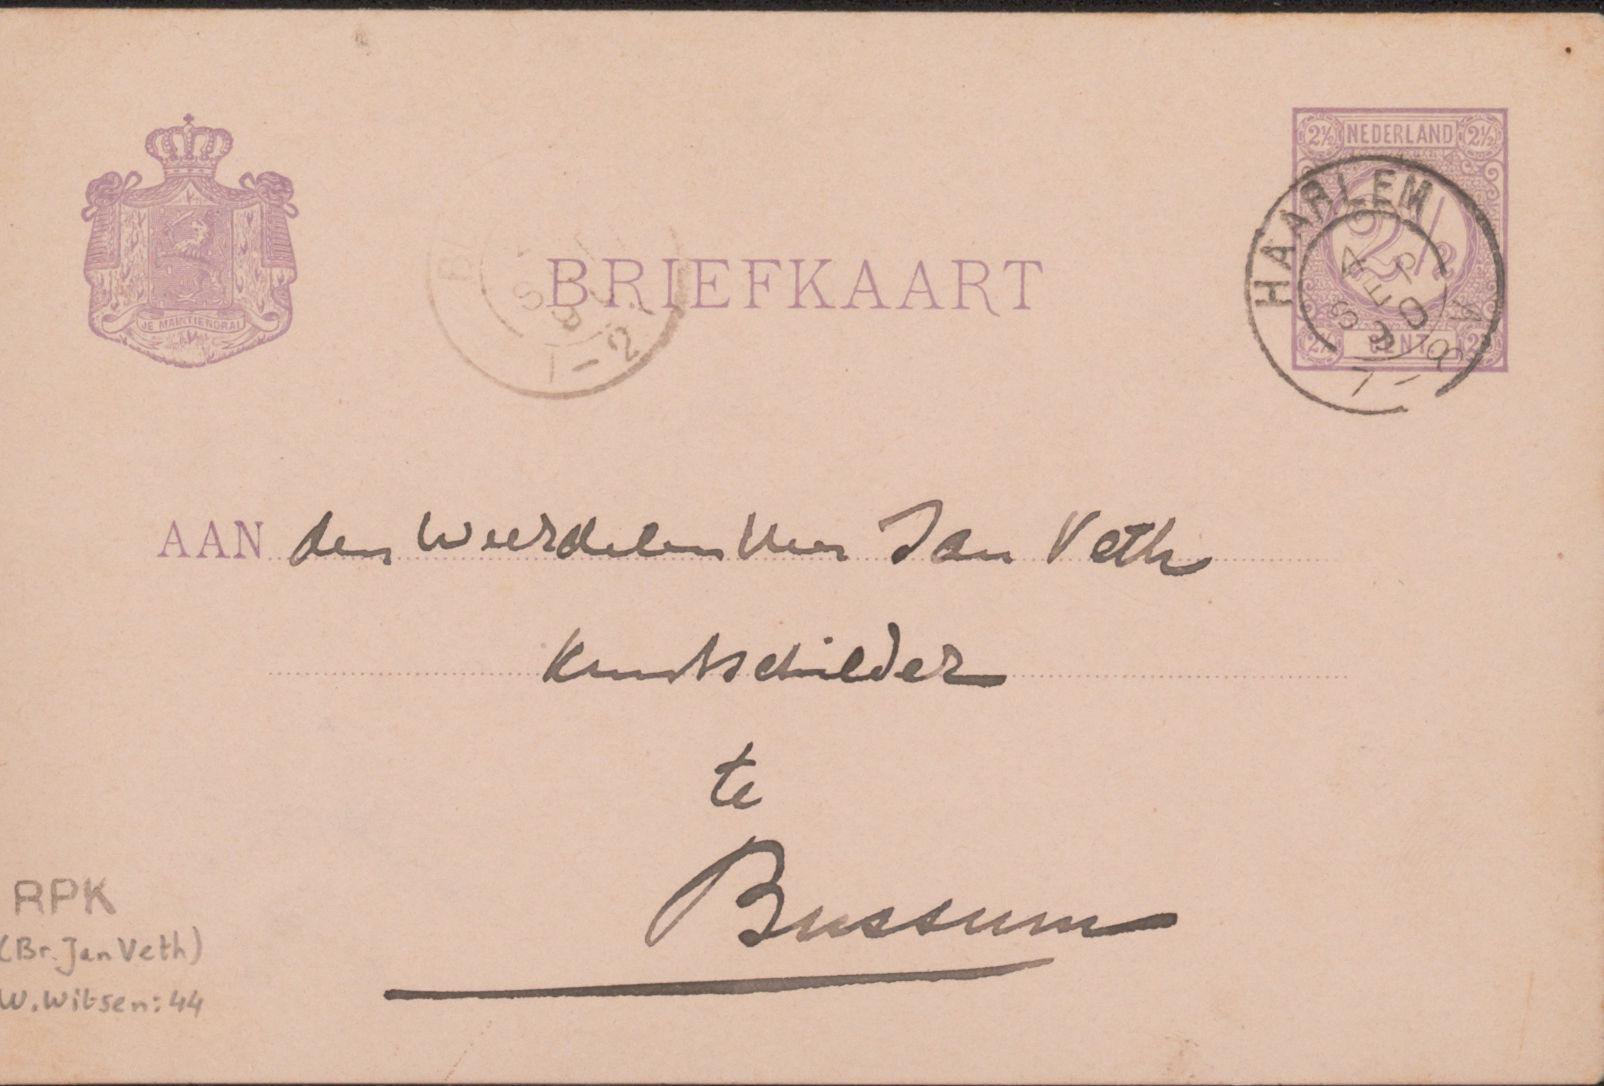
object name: postcard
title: Briefkaart aan Jan Veth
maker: willem witsen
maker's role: draughtsman, painter, print maker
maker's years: 1860-1923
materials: cardboard, ink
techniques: pen, writing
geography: haarlem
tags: dordrecht, designer, jan veth, haarlem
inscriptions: collector's mark: ‘RPK’